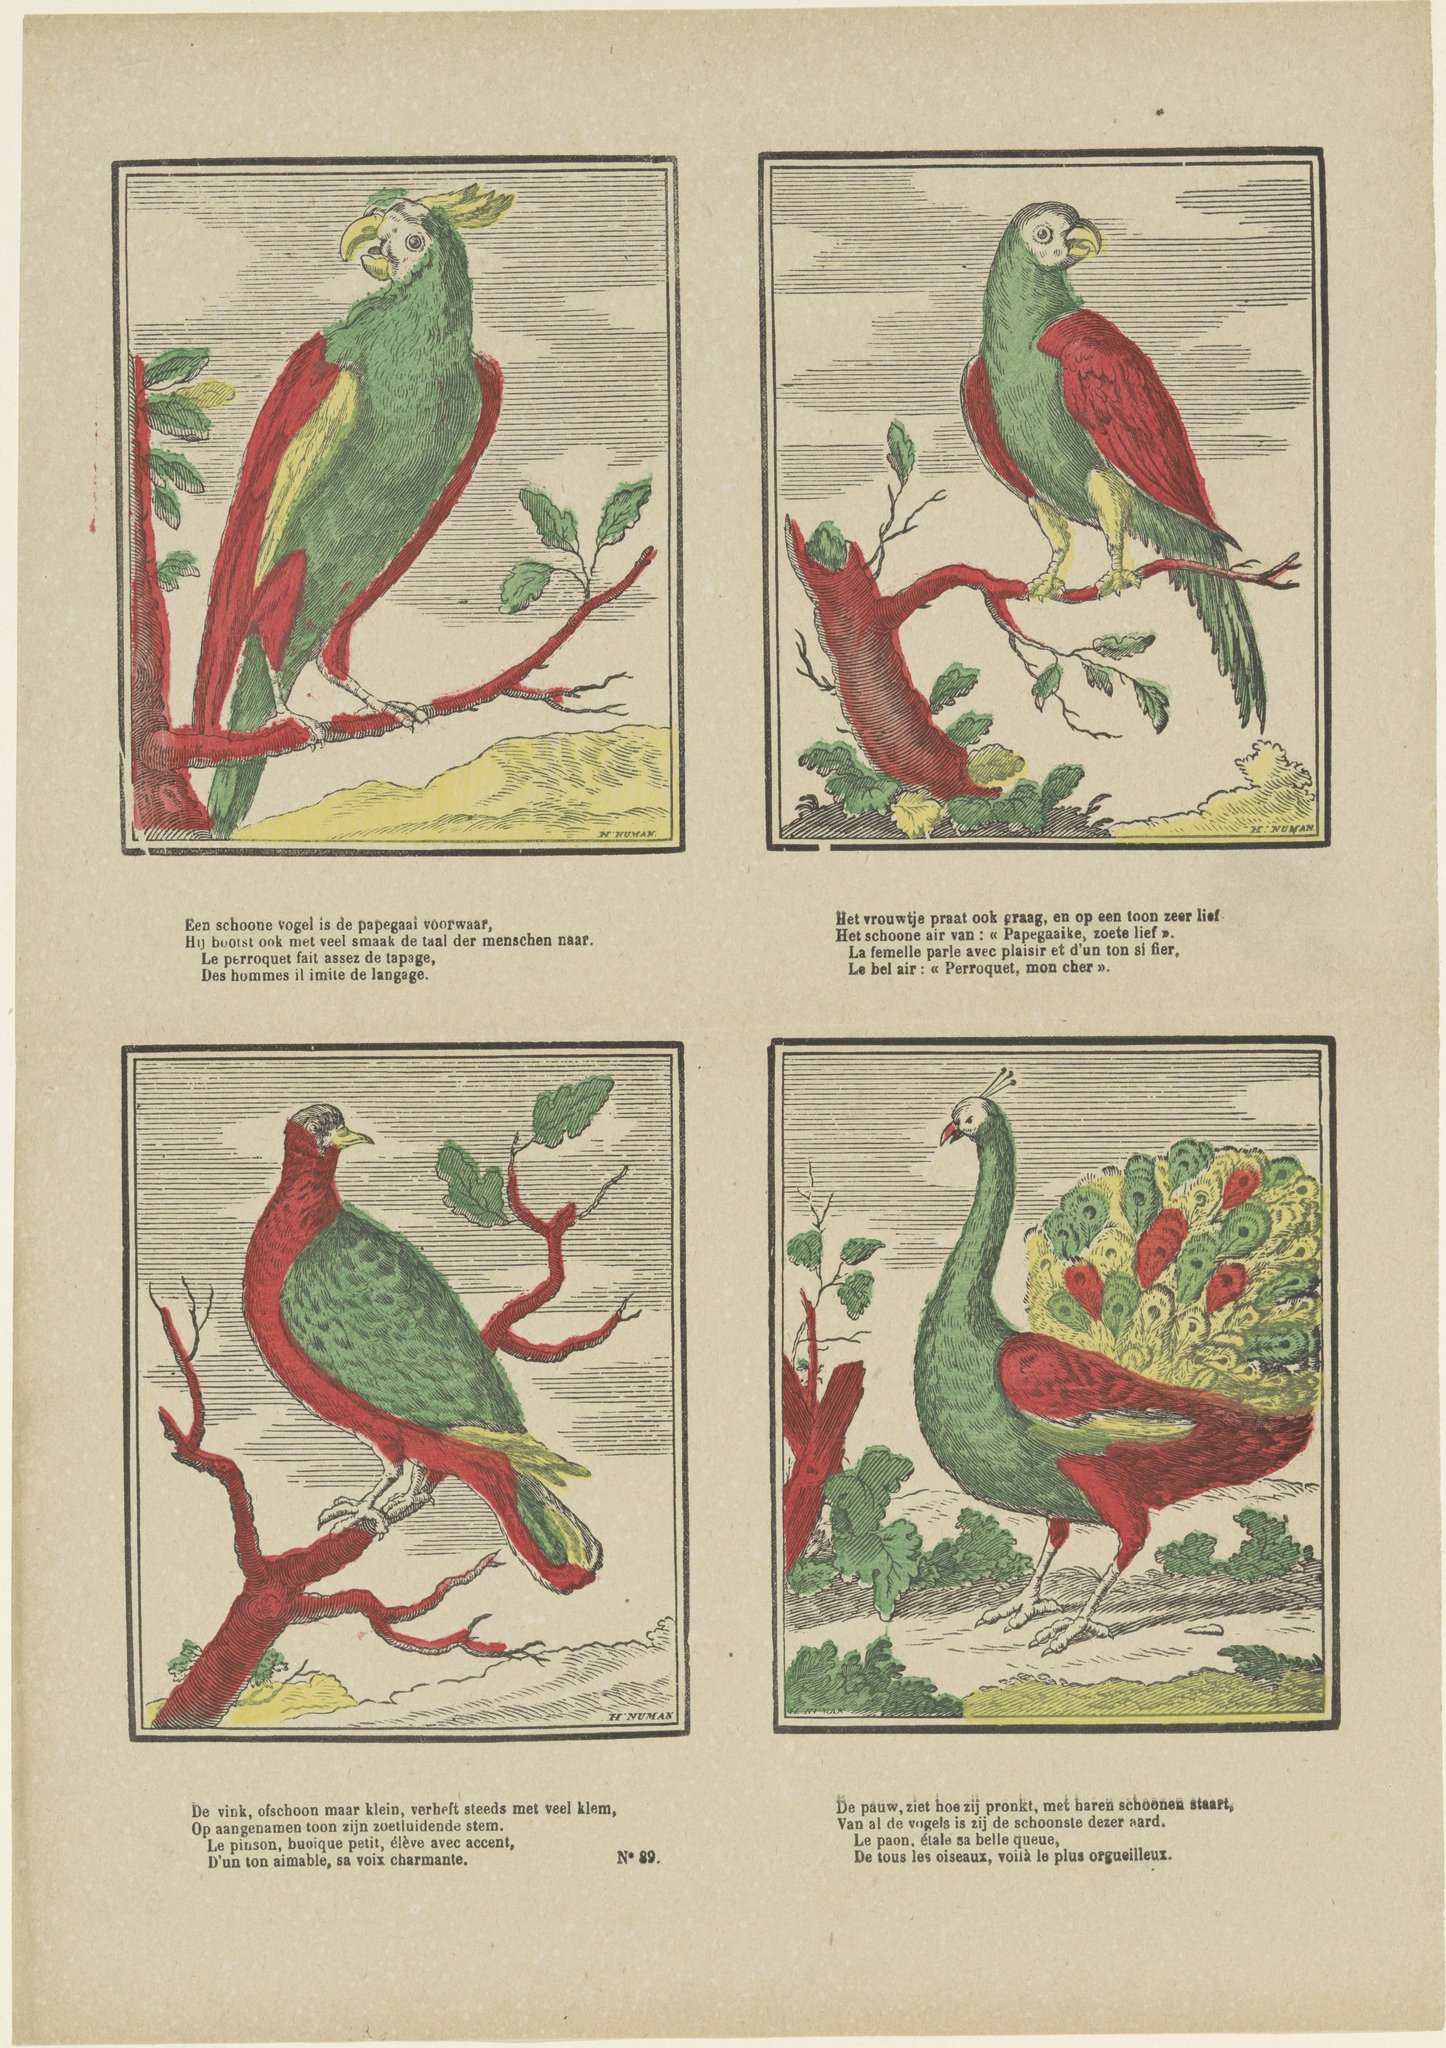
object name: popular print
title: Vogels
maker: franciscus antonius beersmans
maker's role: publisher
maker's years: 1840-1897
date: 1866-1902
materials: paper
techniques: colour, letterpress printing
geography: turnhout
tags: birds, ornamental birds: parrot, ornamental birds: peacock, song-birds: finch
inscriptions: collector's mark: Lugt 2760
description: Blad met 4 voorstellingen van vogels, waaronder papegaaien, een vink en een pauw. Onder elke afbeelding een tweeregelig vers in het Nederlands en in het Frans. Genummerd midden onder: No 89.